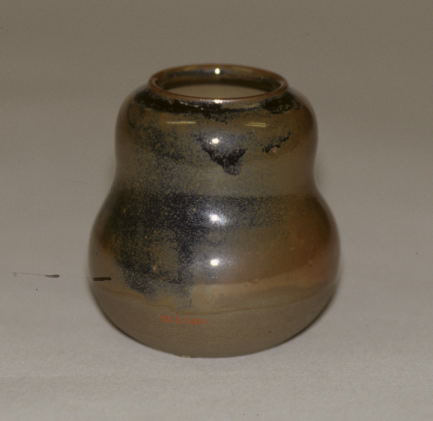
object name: tea jar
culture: japanese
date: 1680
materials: clay, glaze